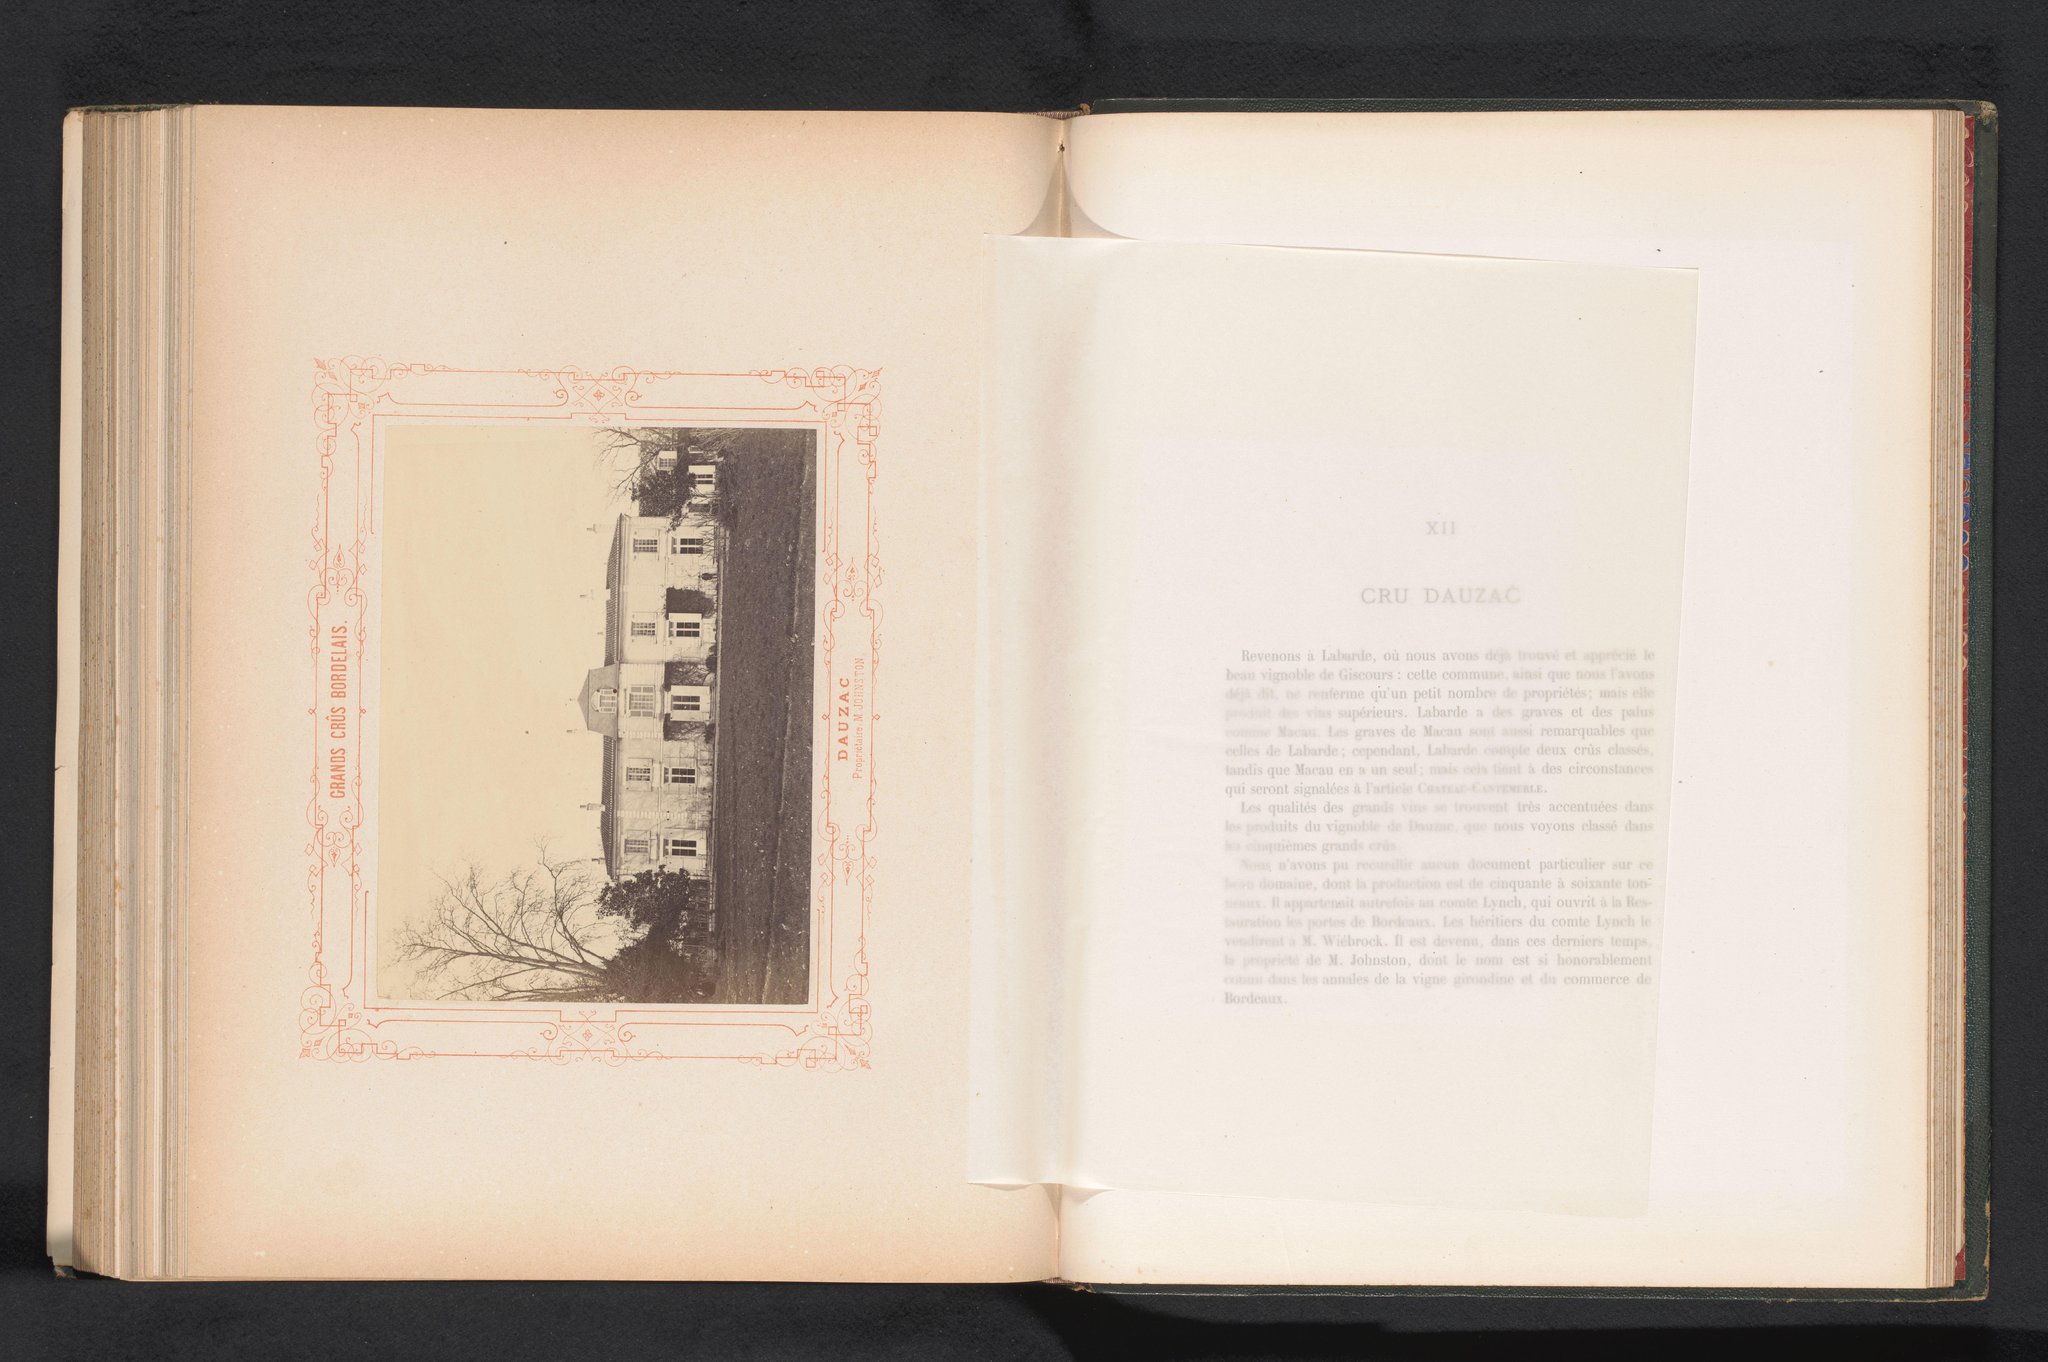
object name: page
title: Grands Crûs Bordelais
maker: alfred danflou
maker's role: fotograaf, schrijver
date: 1862-1867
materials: photographic support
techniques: albumen print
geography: labarde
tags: castle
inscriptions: inscription: ‘Propriétaire: M. JOHNSTON.’